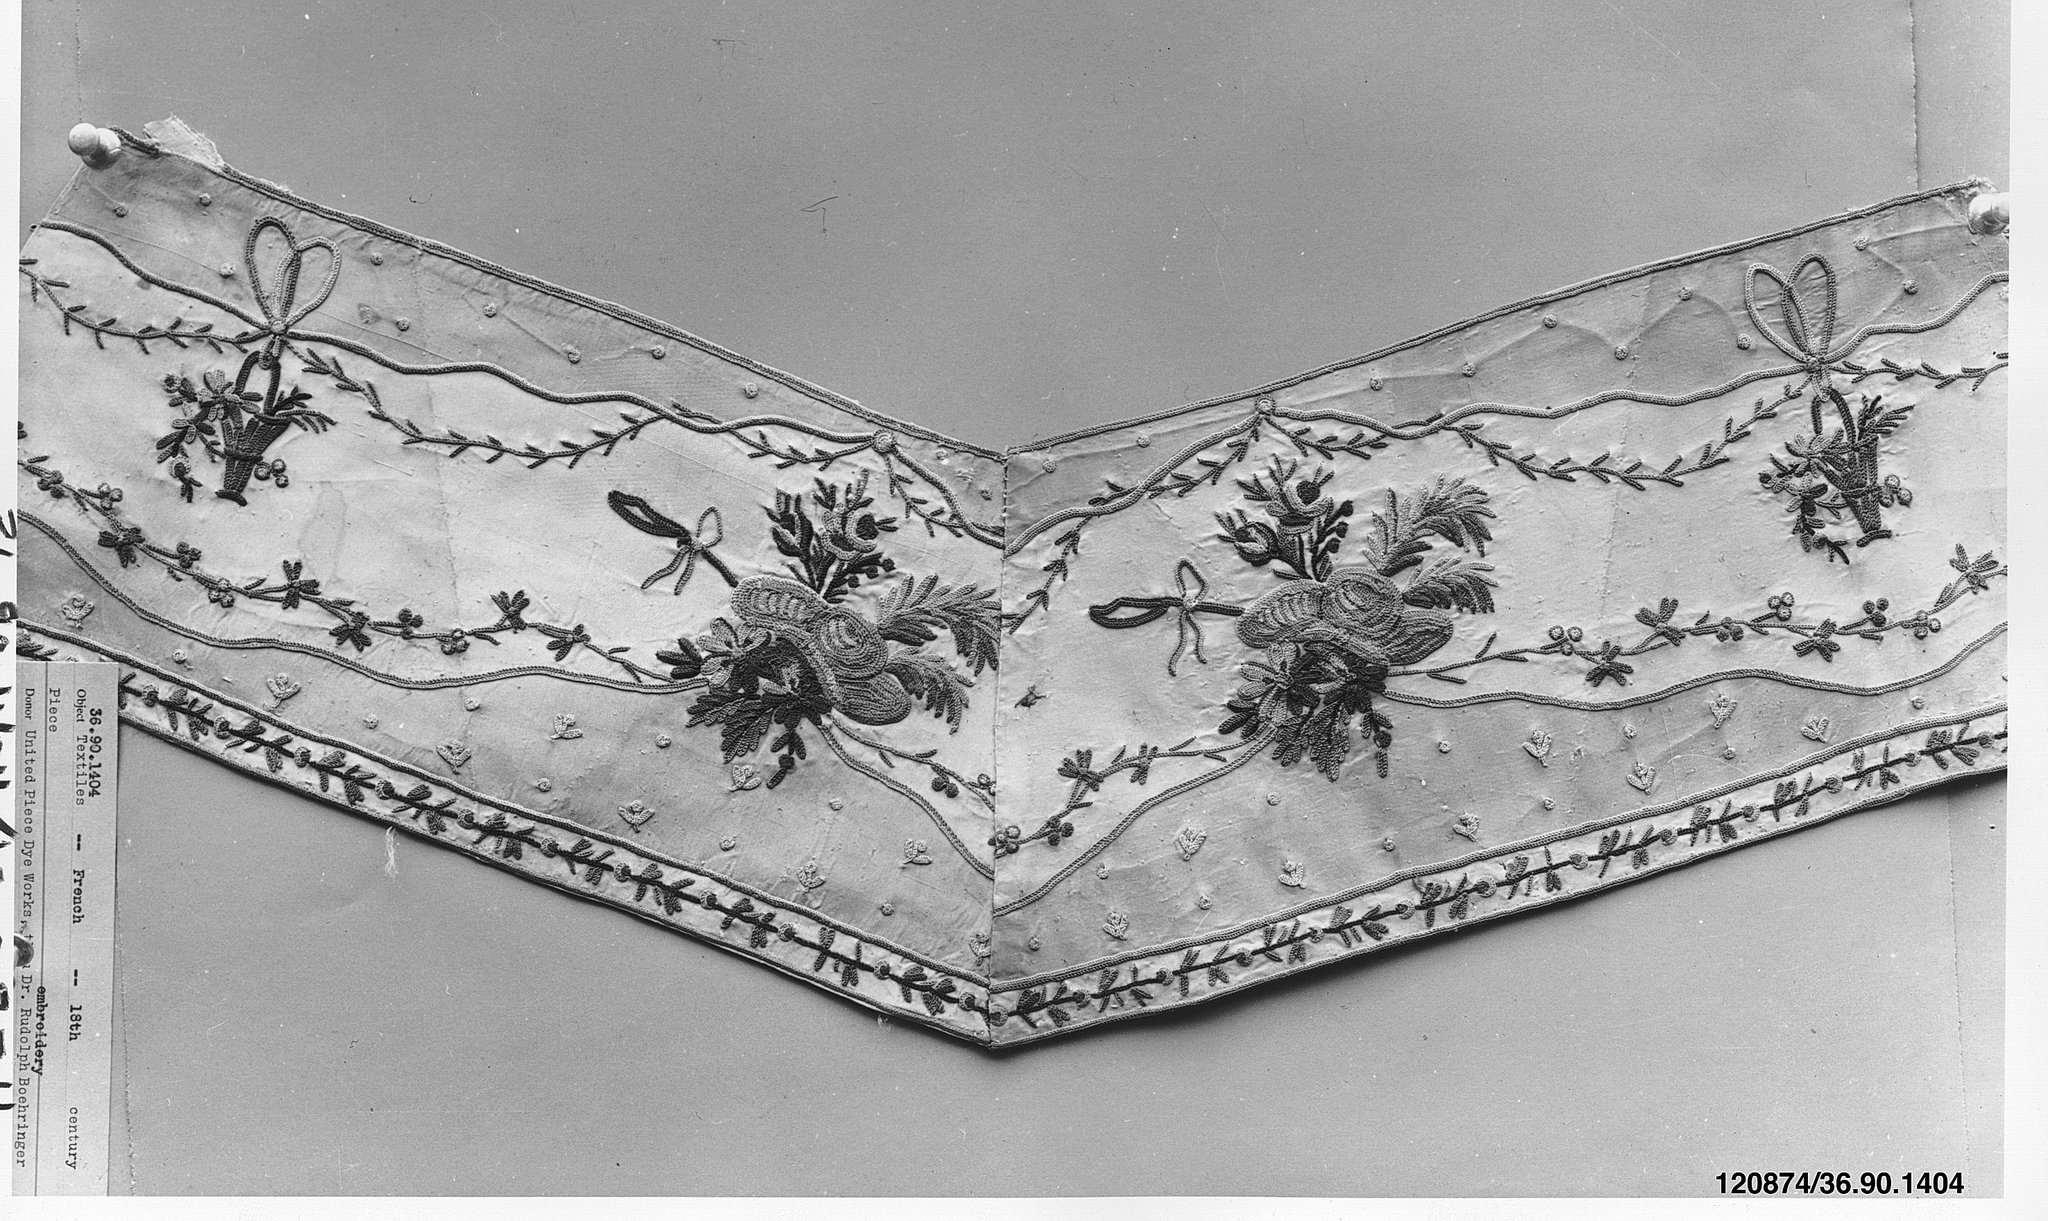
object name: piece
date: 1701-1800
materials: silk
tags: leaves